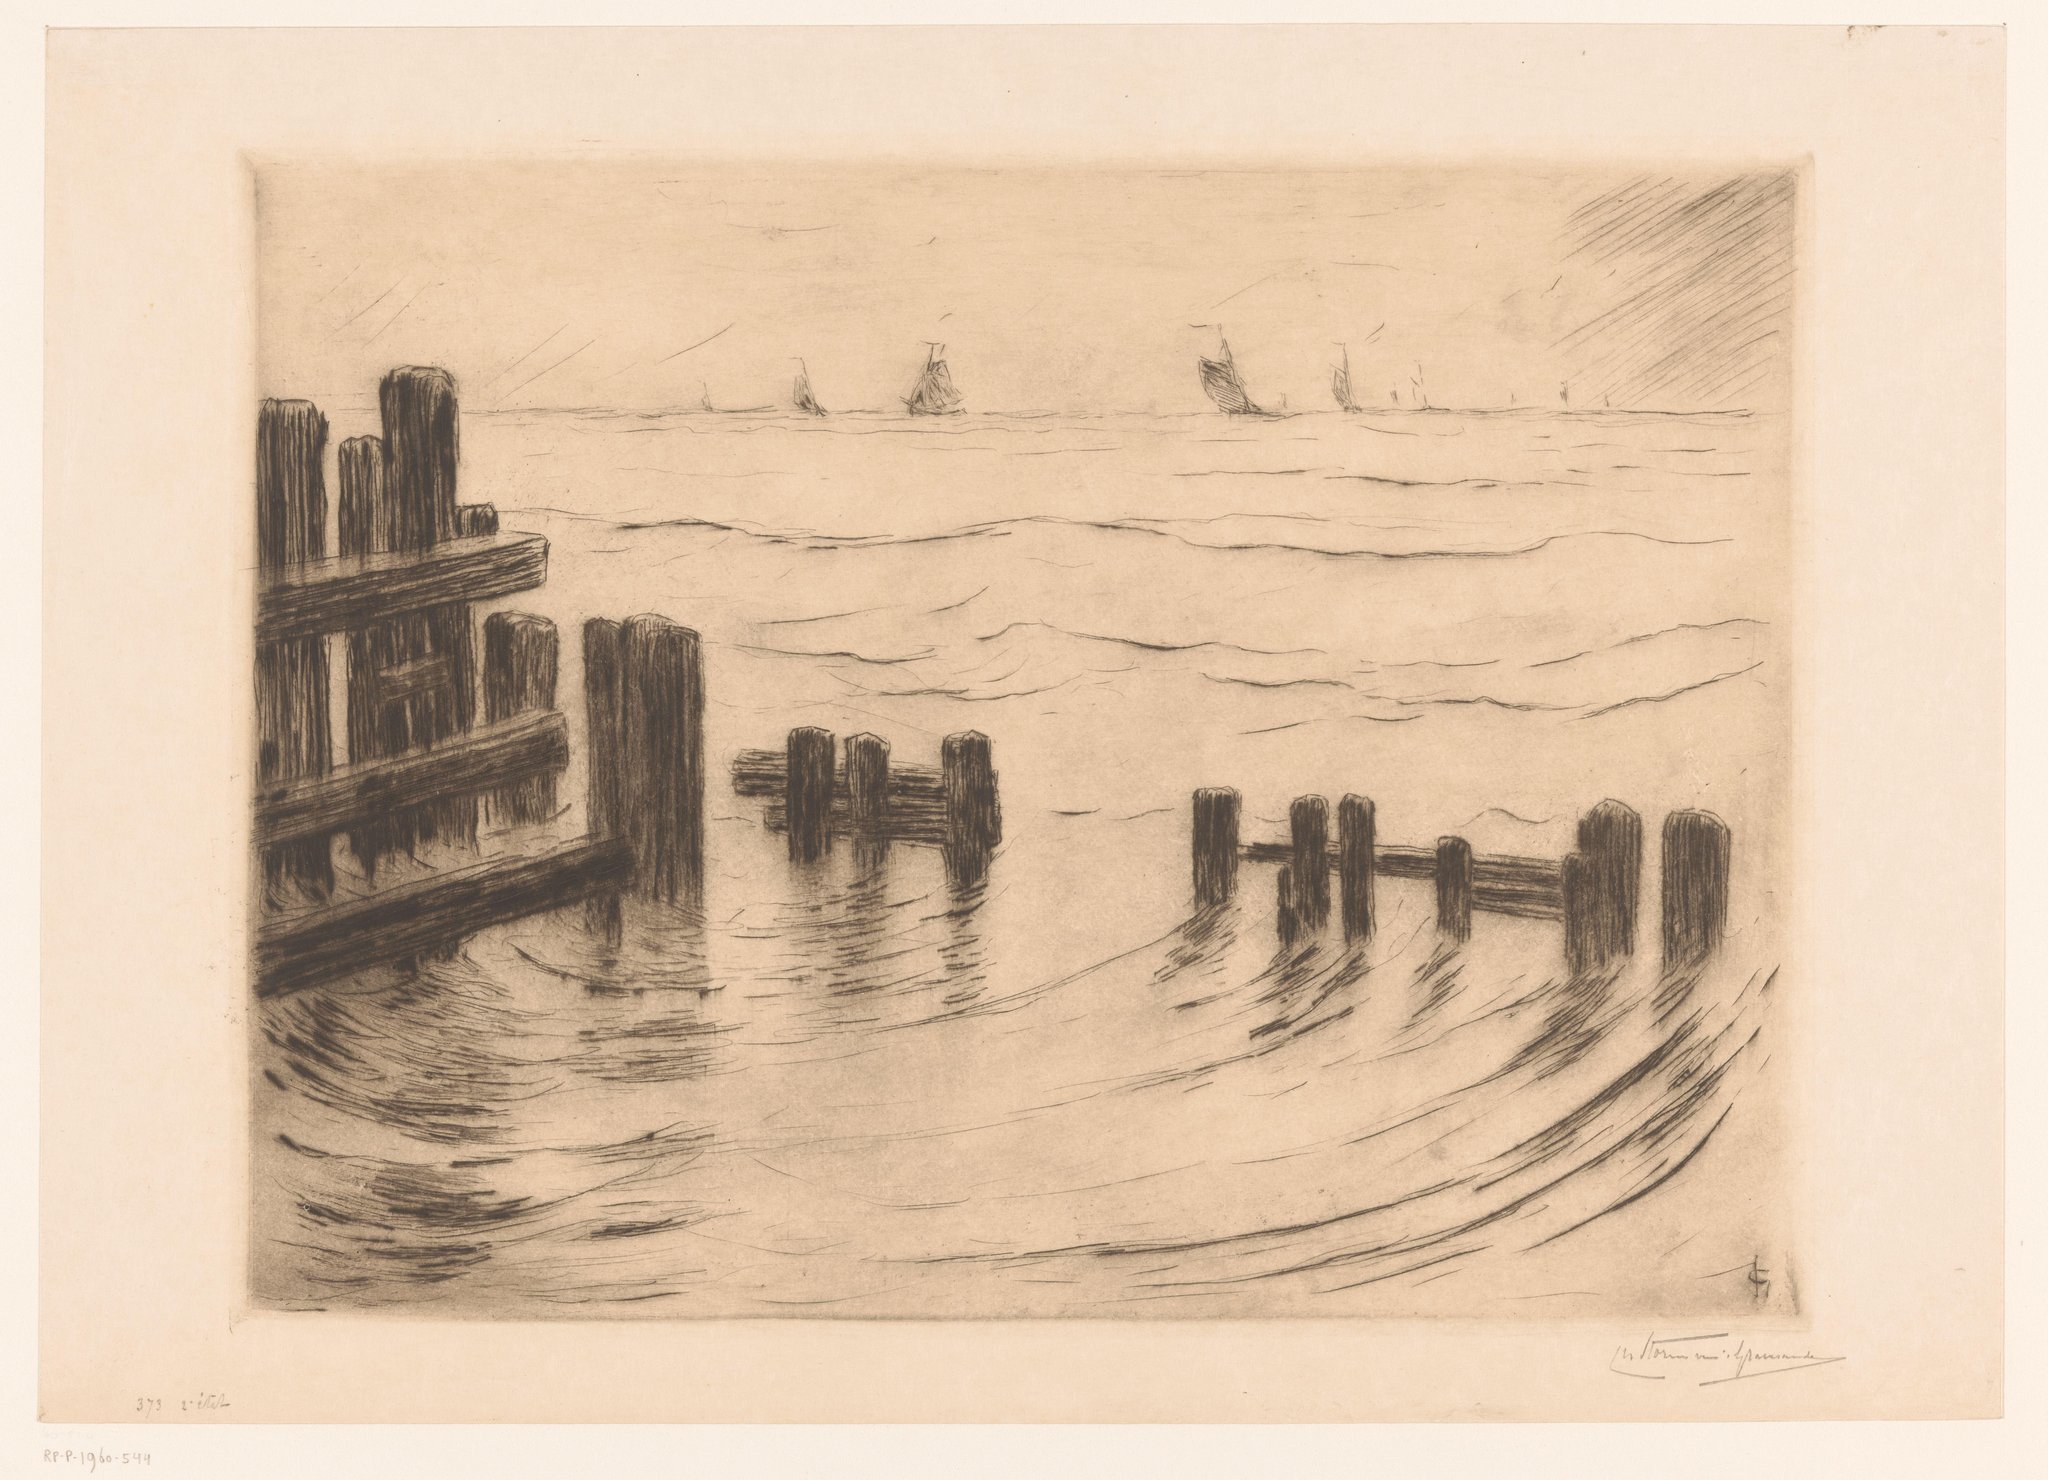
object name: print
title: Brise-lames, Flessingue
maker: carel nicolaas storm van s-gravesande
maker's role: draughtsman, print maker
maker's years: 1841-1924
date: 1889-1903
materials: paper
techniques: drypoint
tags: sea (seascape), coastal protection work, breakwater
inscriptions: number: ‘373’, collector's mark: Lugt 2228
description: Mogelijk vermeld in: Storm van 's-Gravesande, Charles. Catalogue des eaux-fortes et lithographies. New York: s.n., 1903, of in een onbekende latere uitgave van het manuscript. Vermoedelijk vermeld als catalogusnummer 373.